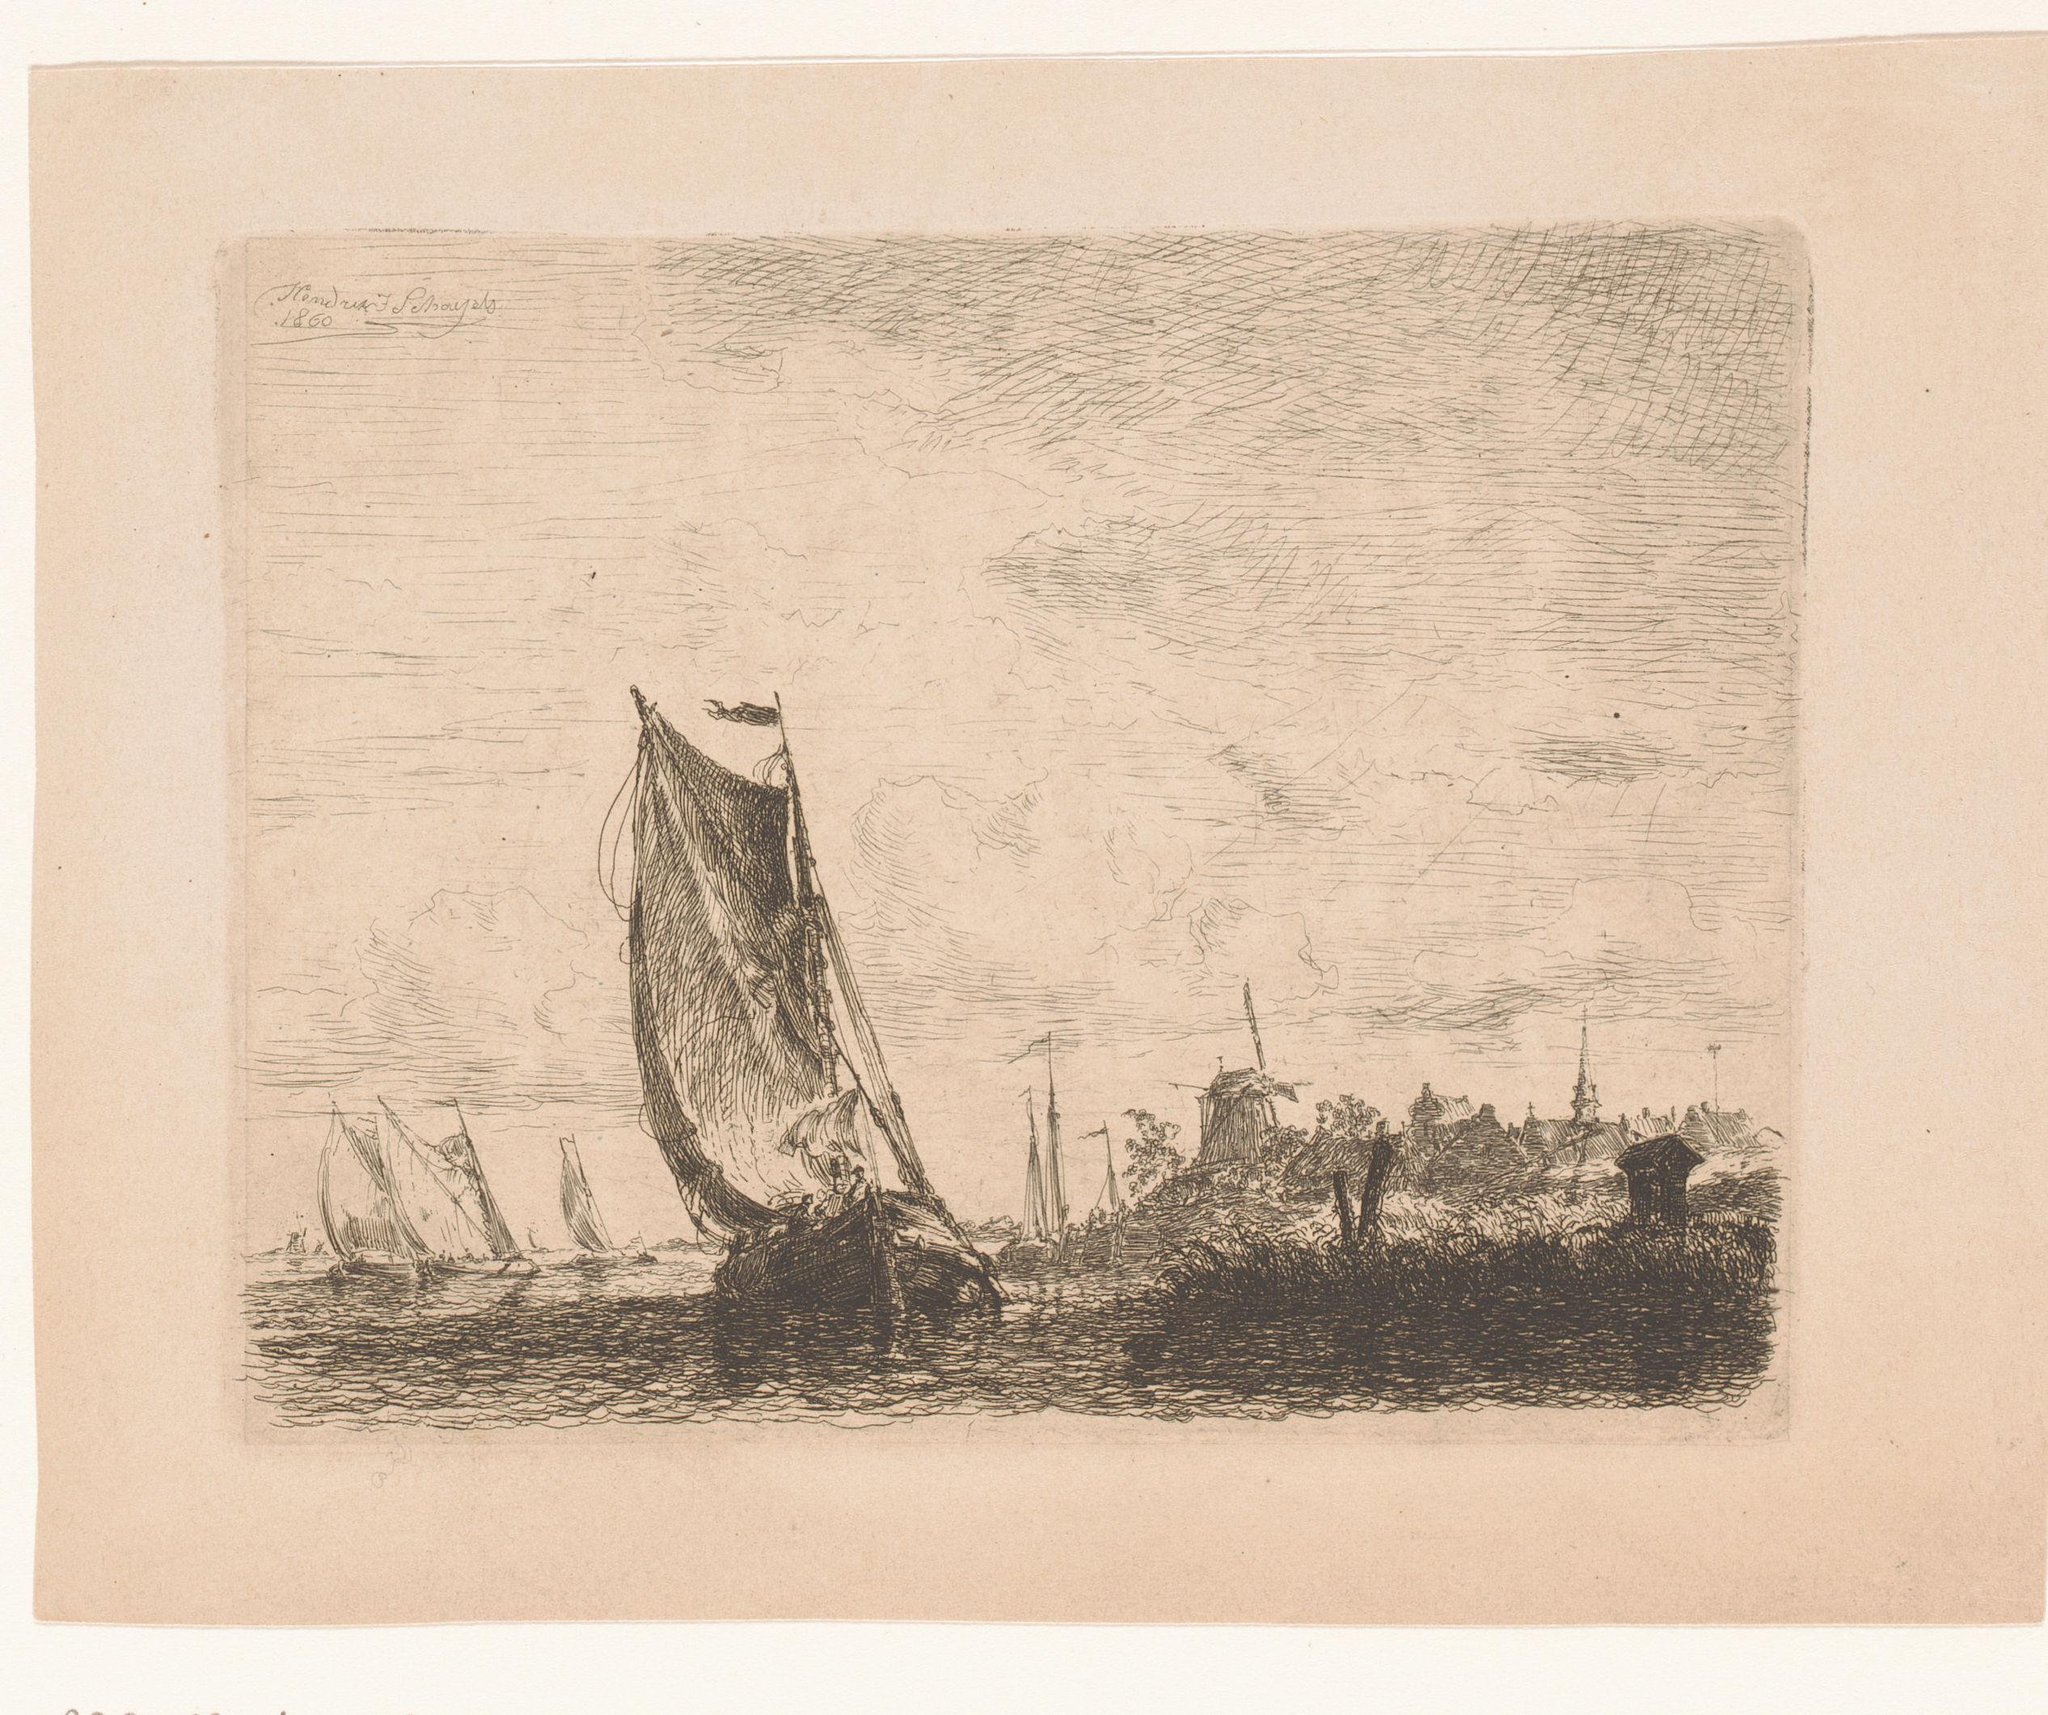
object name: print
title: Boten op de Schelde met rechts een dorp met molen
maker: henri françois schaefels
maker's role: print maker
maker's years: 1827-1904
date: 1860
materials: paper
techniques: etching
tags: sailing-ship, sailing-boat, landscapes with waters, waterscapes, seascapes (in the temperate zone), village, windmill in landscape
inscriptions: collector's mark: Lugt 2228